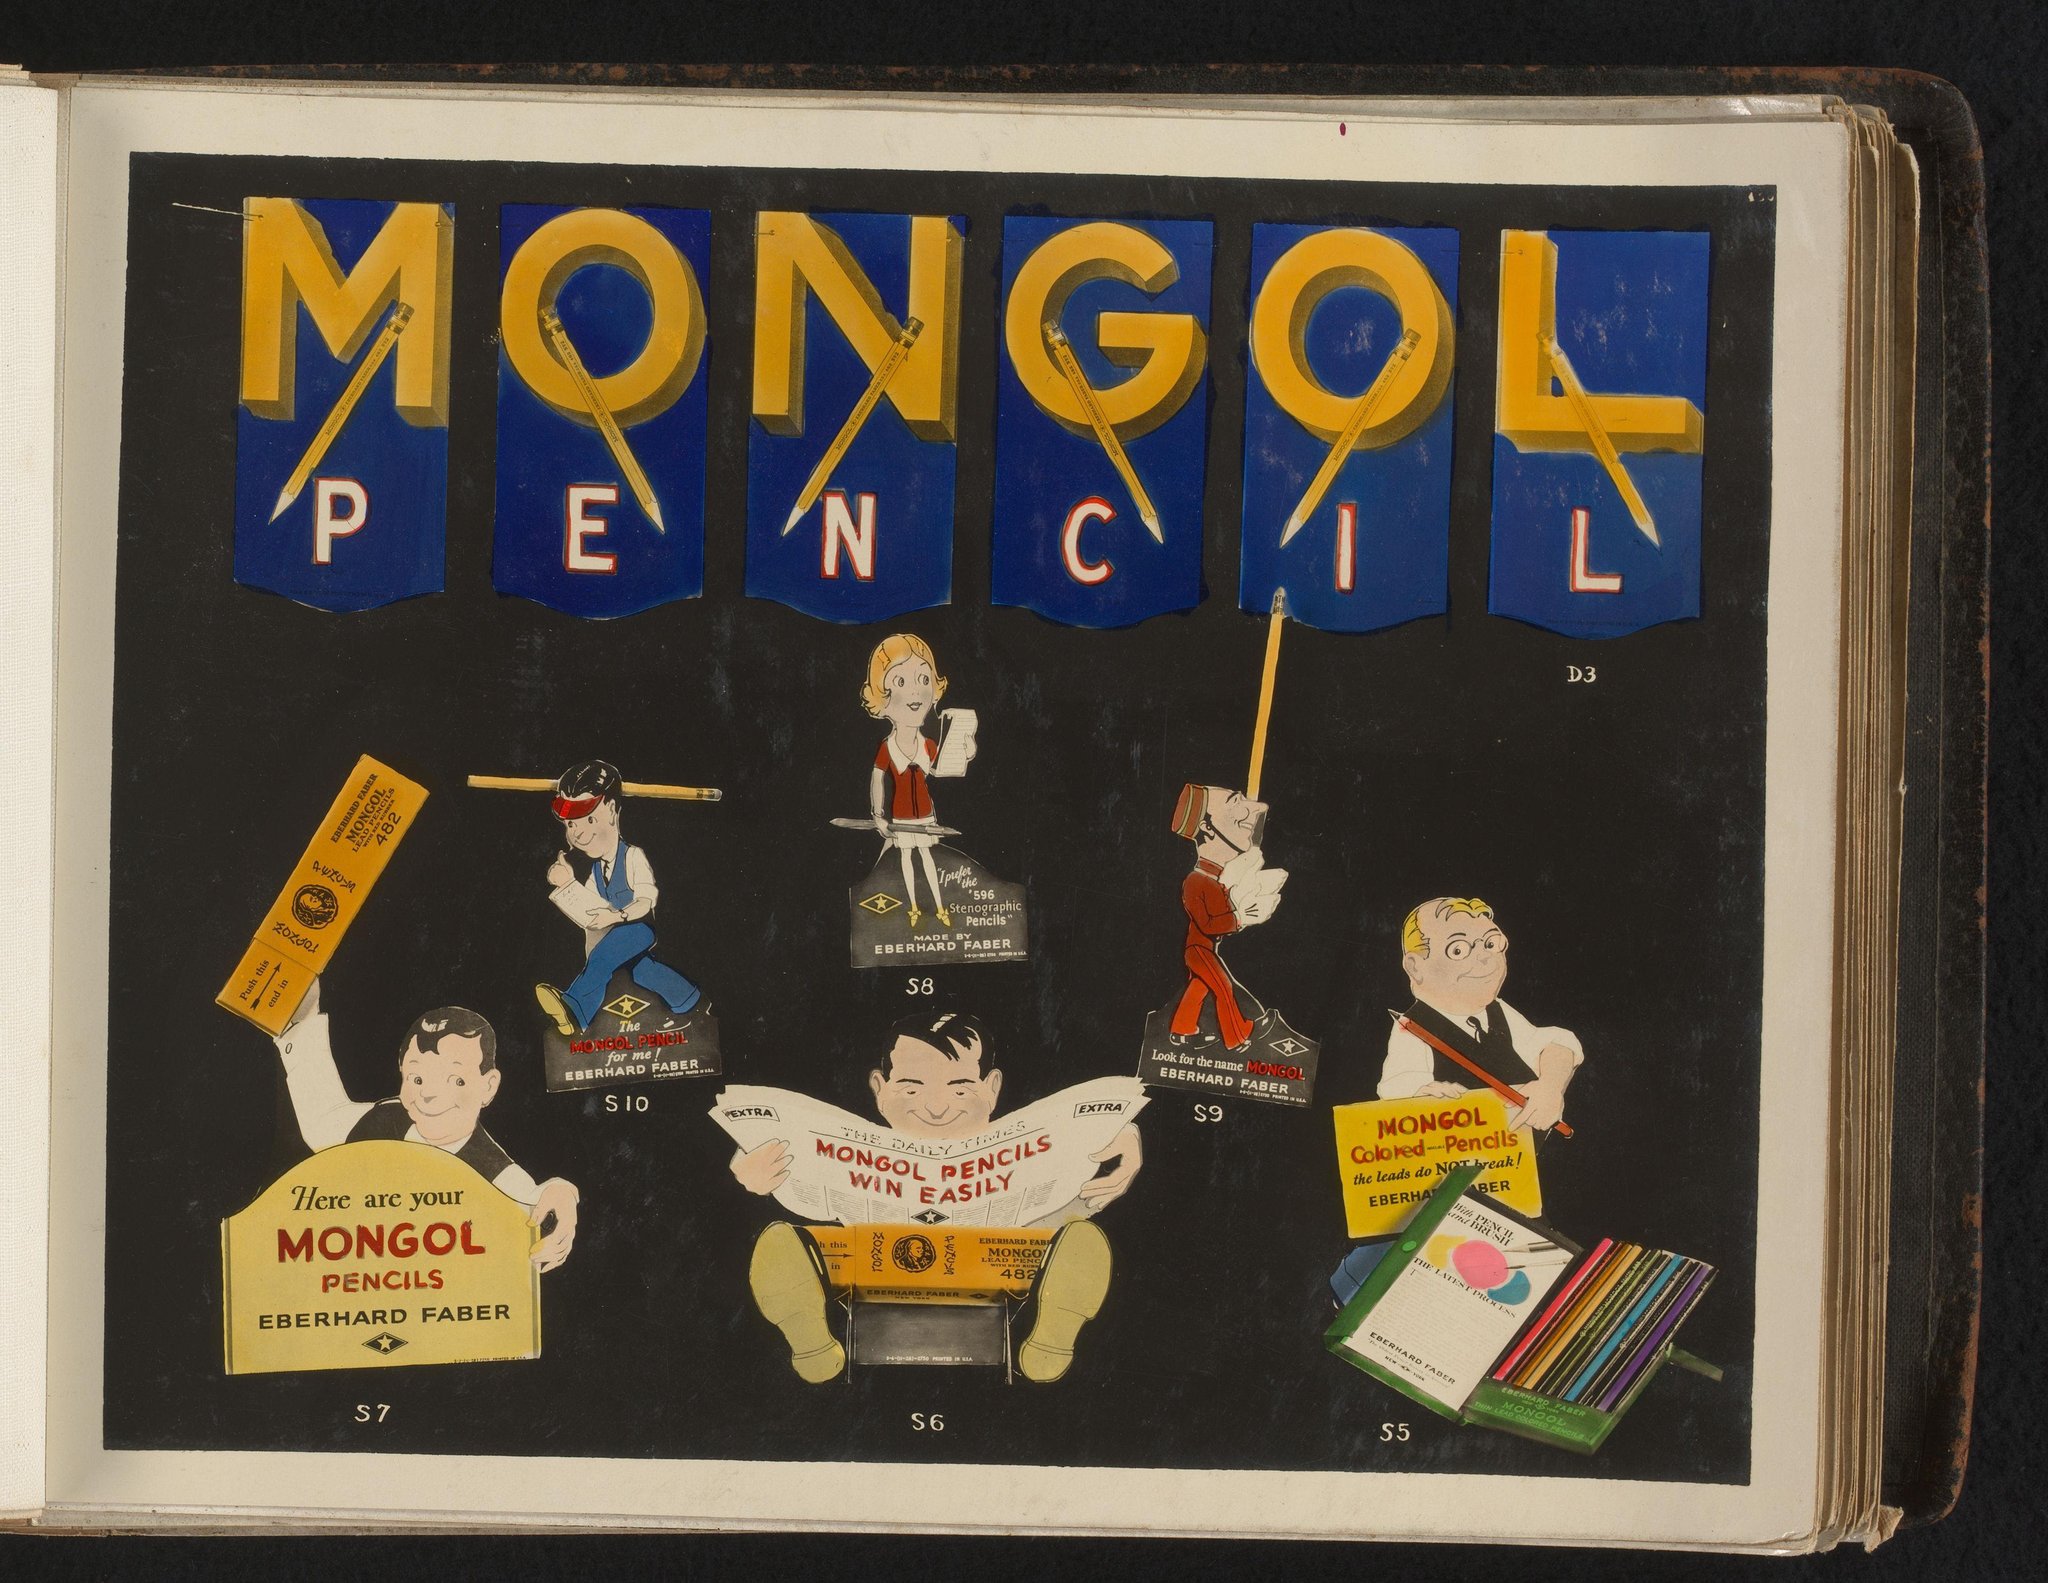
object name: album leaf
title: Reclamemateriaal voor potloden van Eberhard Faber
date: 1915-1935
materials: paper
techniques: gelatin silver print, hand coloring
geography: springfield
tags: pencil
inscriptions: stamp: ‘Paramount/ Commercial Studios/ 145 Chestnut St./ Springfield - Mass.’, number: ‘450’